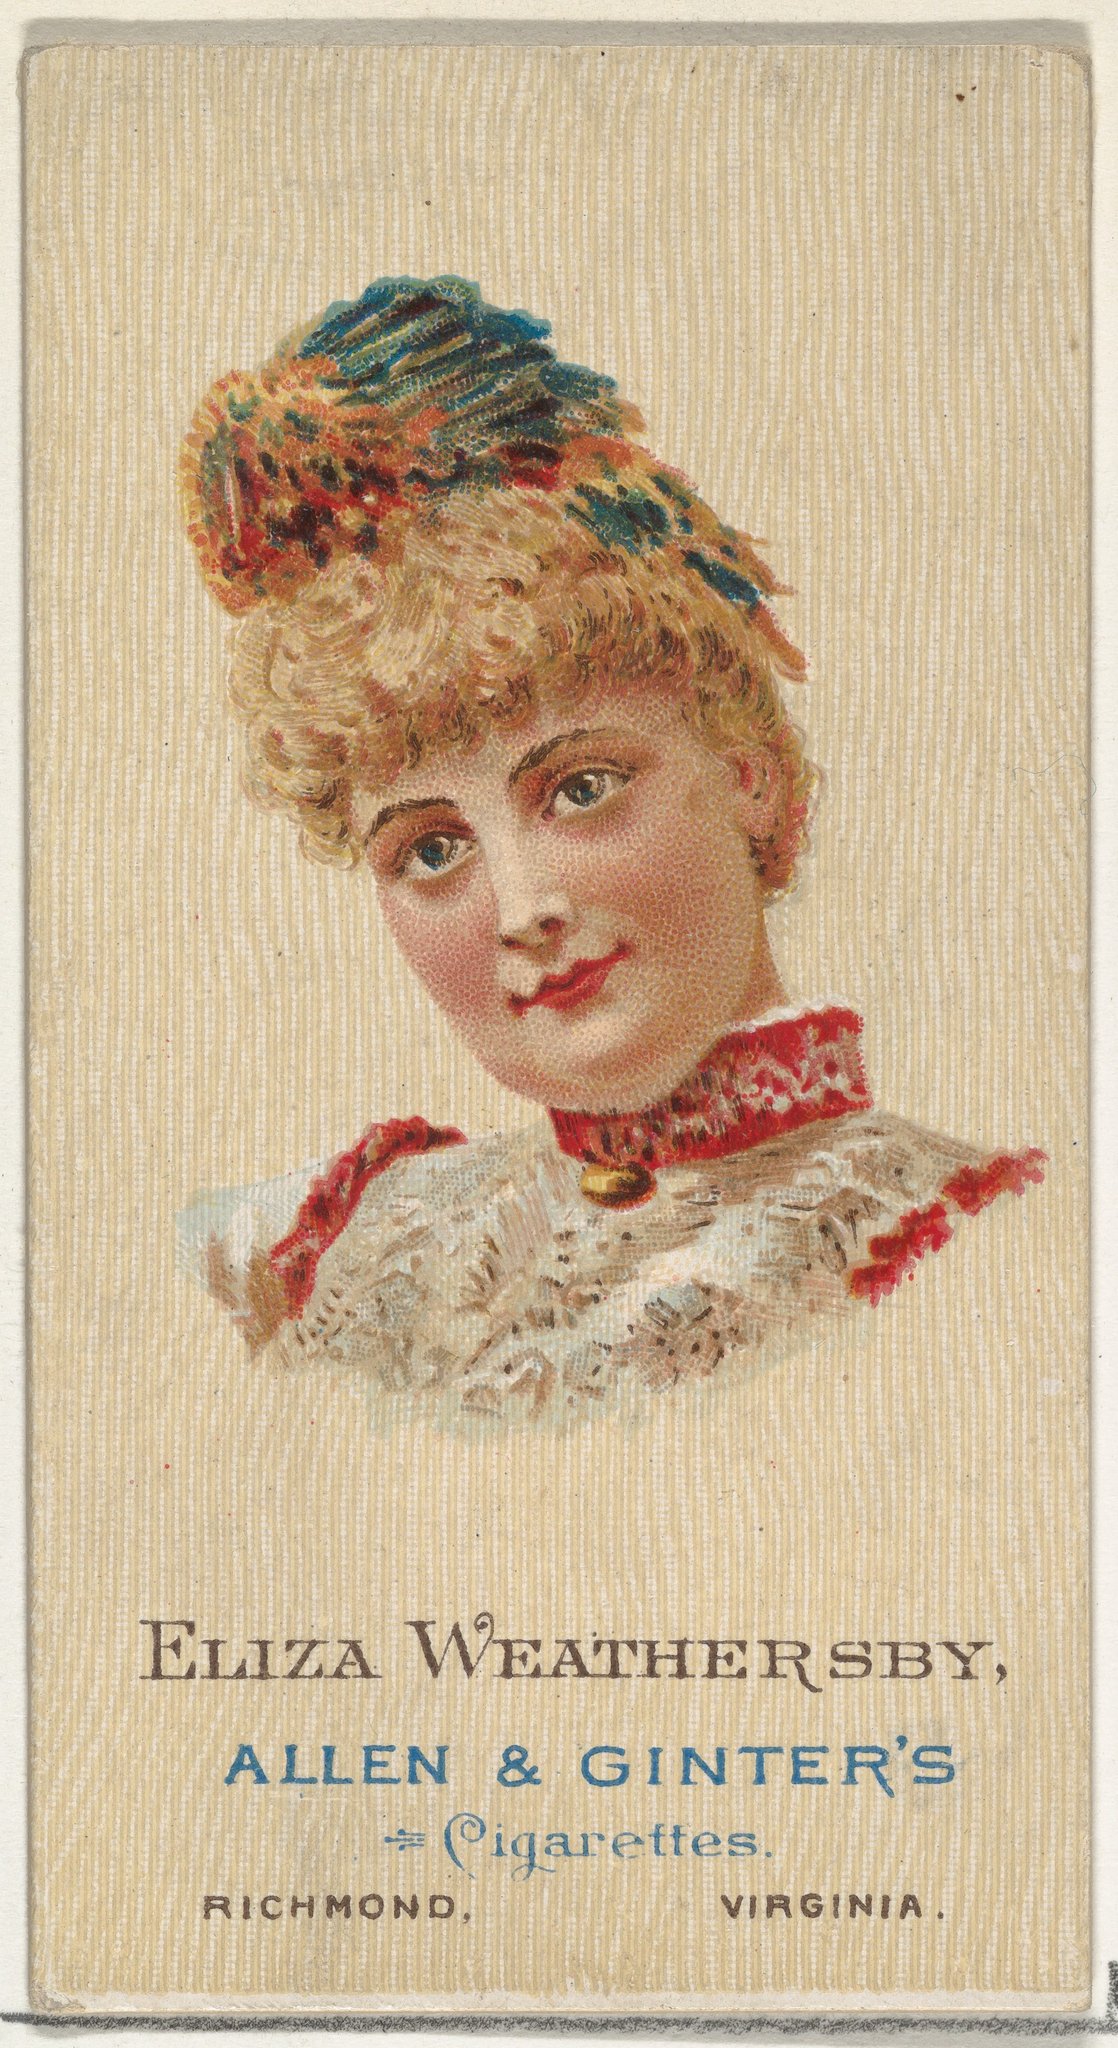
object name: print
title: Eliza Weathersby, from World's Beauties, Series 2 (N27) for Allen & Ginter Cigarettes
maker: allen & ginter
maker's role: publisher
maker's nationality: american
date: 1888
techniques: color lithograph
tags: women